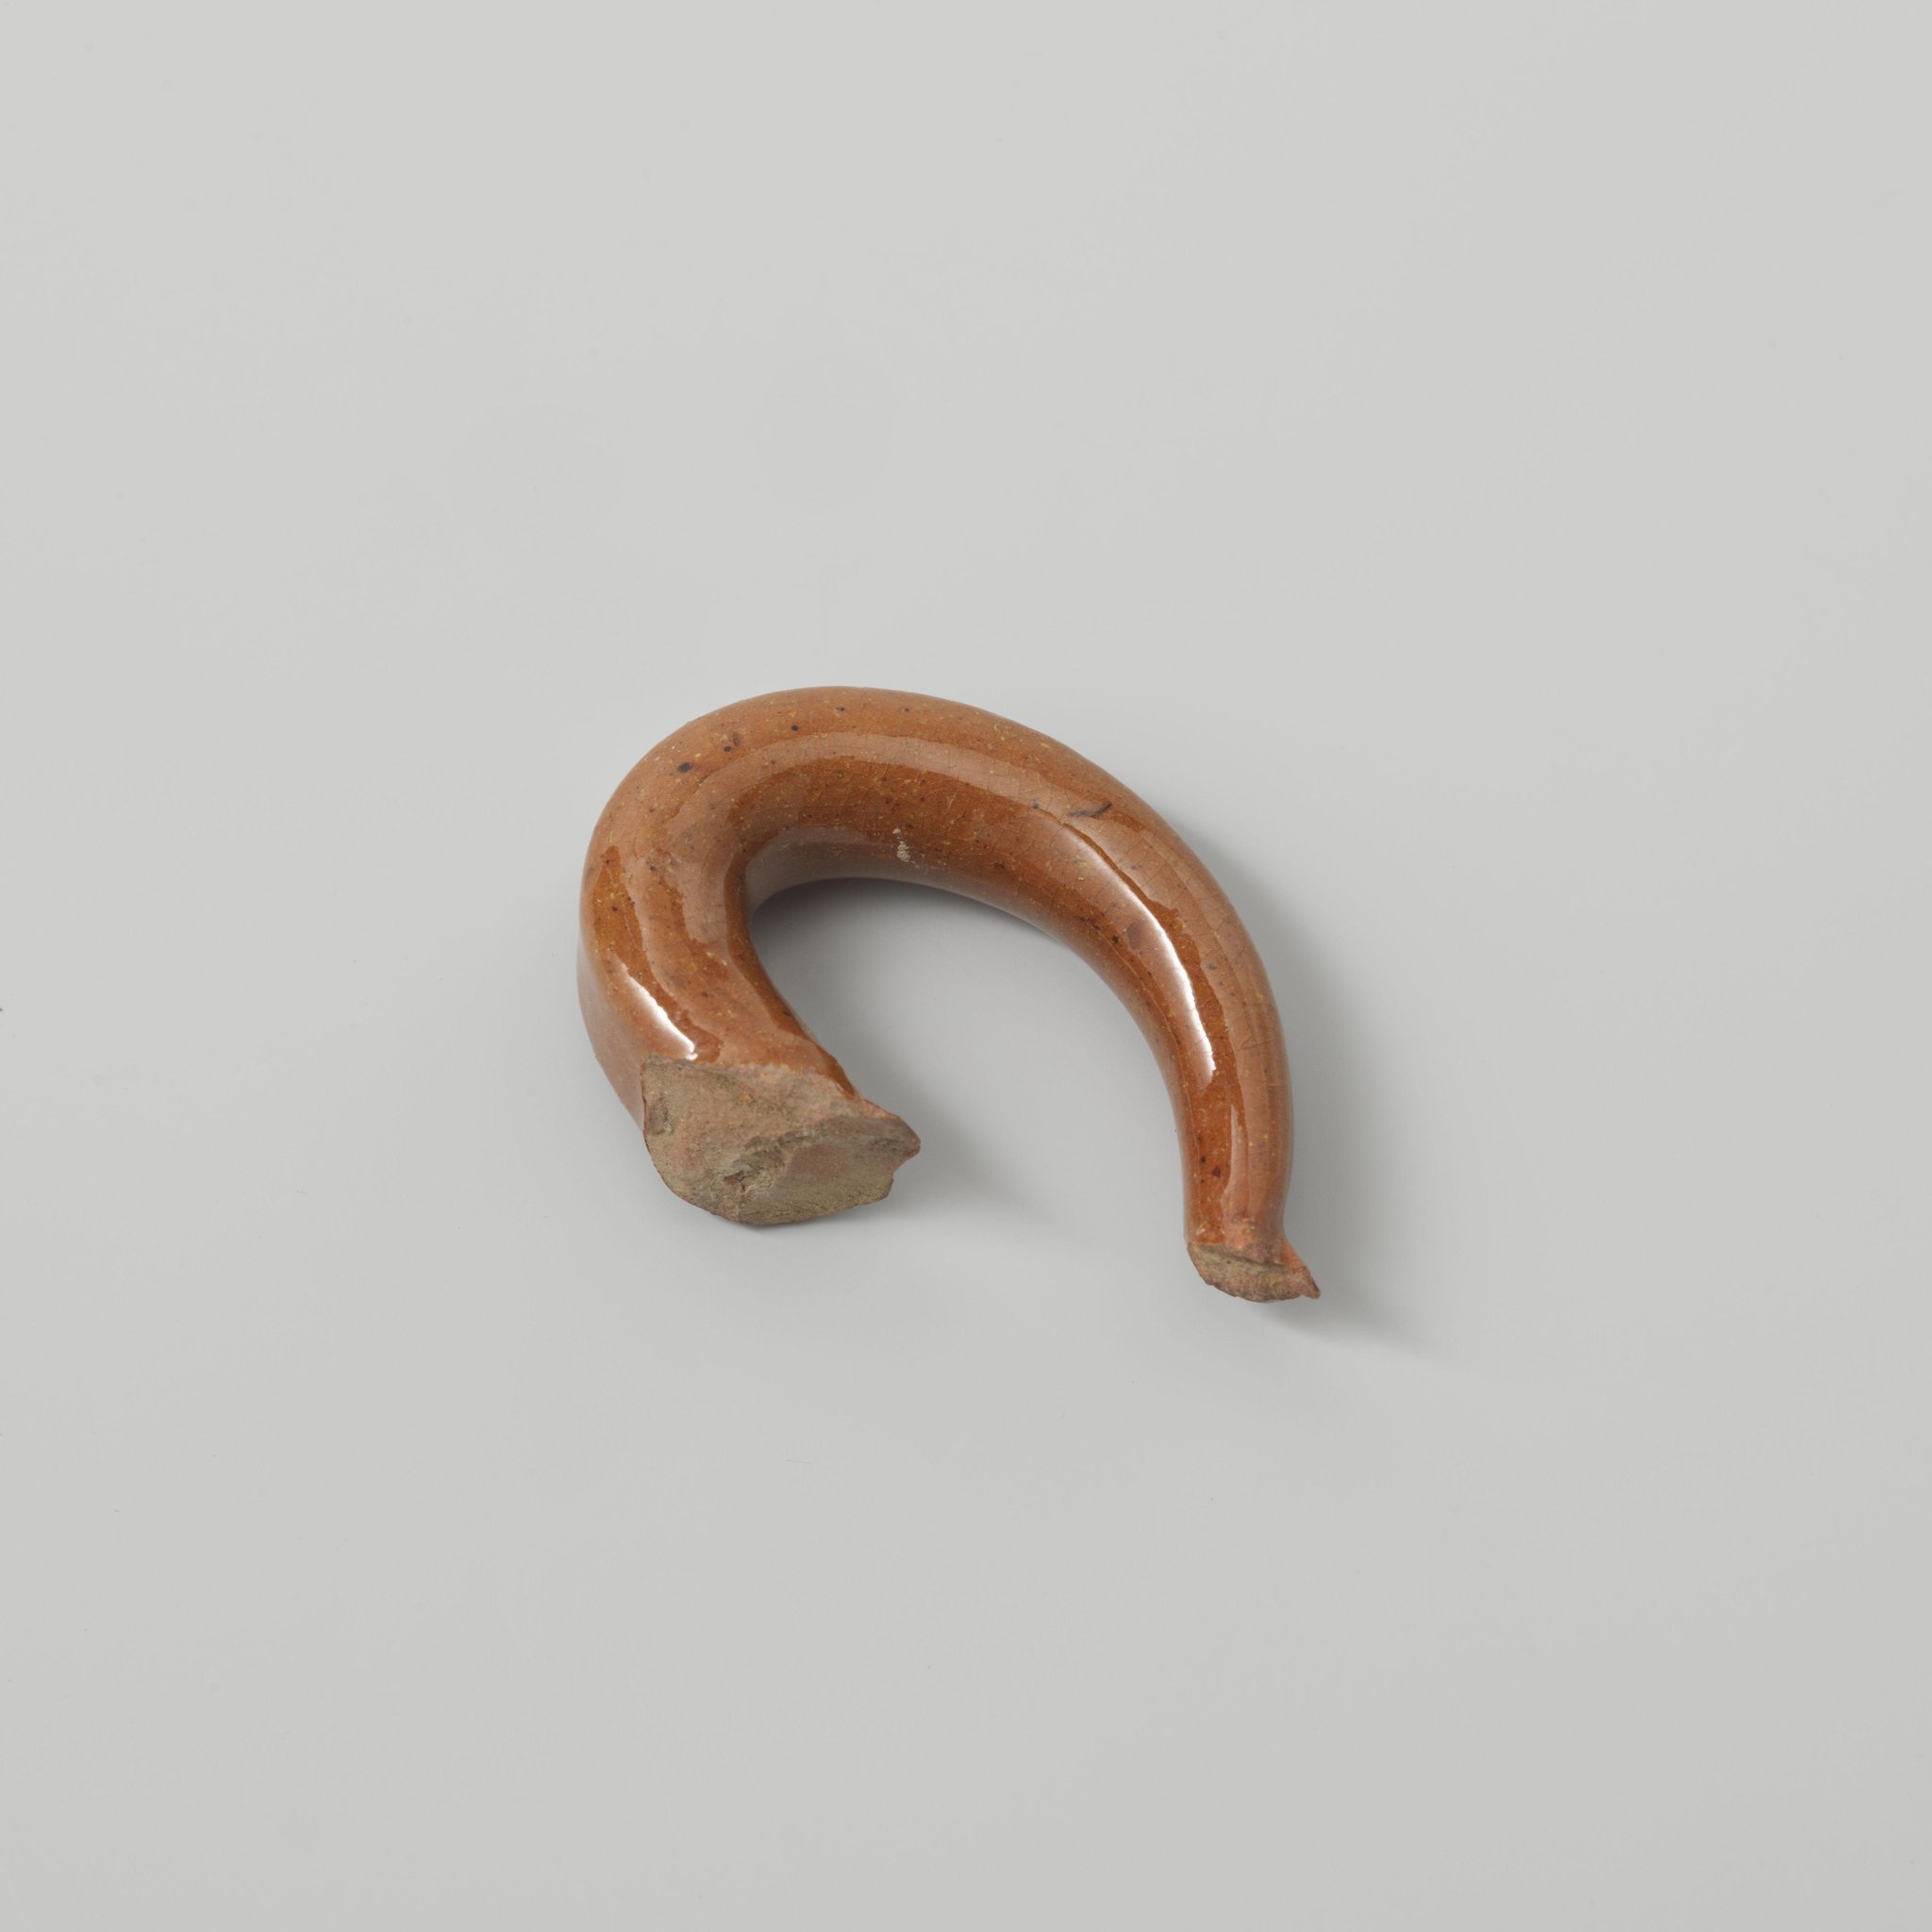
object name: lug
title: Oor van een theepot (De Caluwe bakafval)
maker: jacobus de caluwe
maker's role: plateelbakkerij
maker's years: -1730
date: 1700-1725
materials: earthenware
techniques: firing, vitrification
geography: delft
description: Toegeschreven aan Jacobus de Caluwe, omdat dit voorwerp samen met gemerkte stukken (‘Jacobus De Caluwe’ en rennend hert) gevonden is op de plaats waar zich De Caluwes tweede werkplaats bevond. Er is een duidelijke stilistische overeenkomst tussen de gemerkte en niet gemerkte voorwerpen uit deze archeologische vondst.